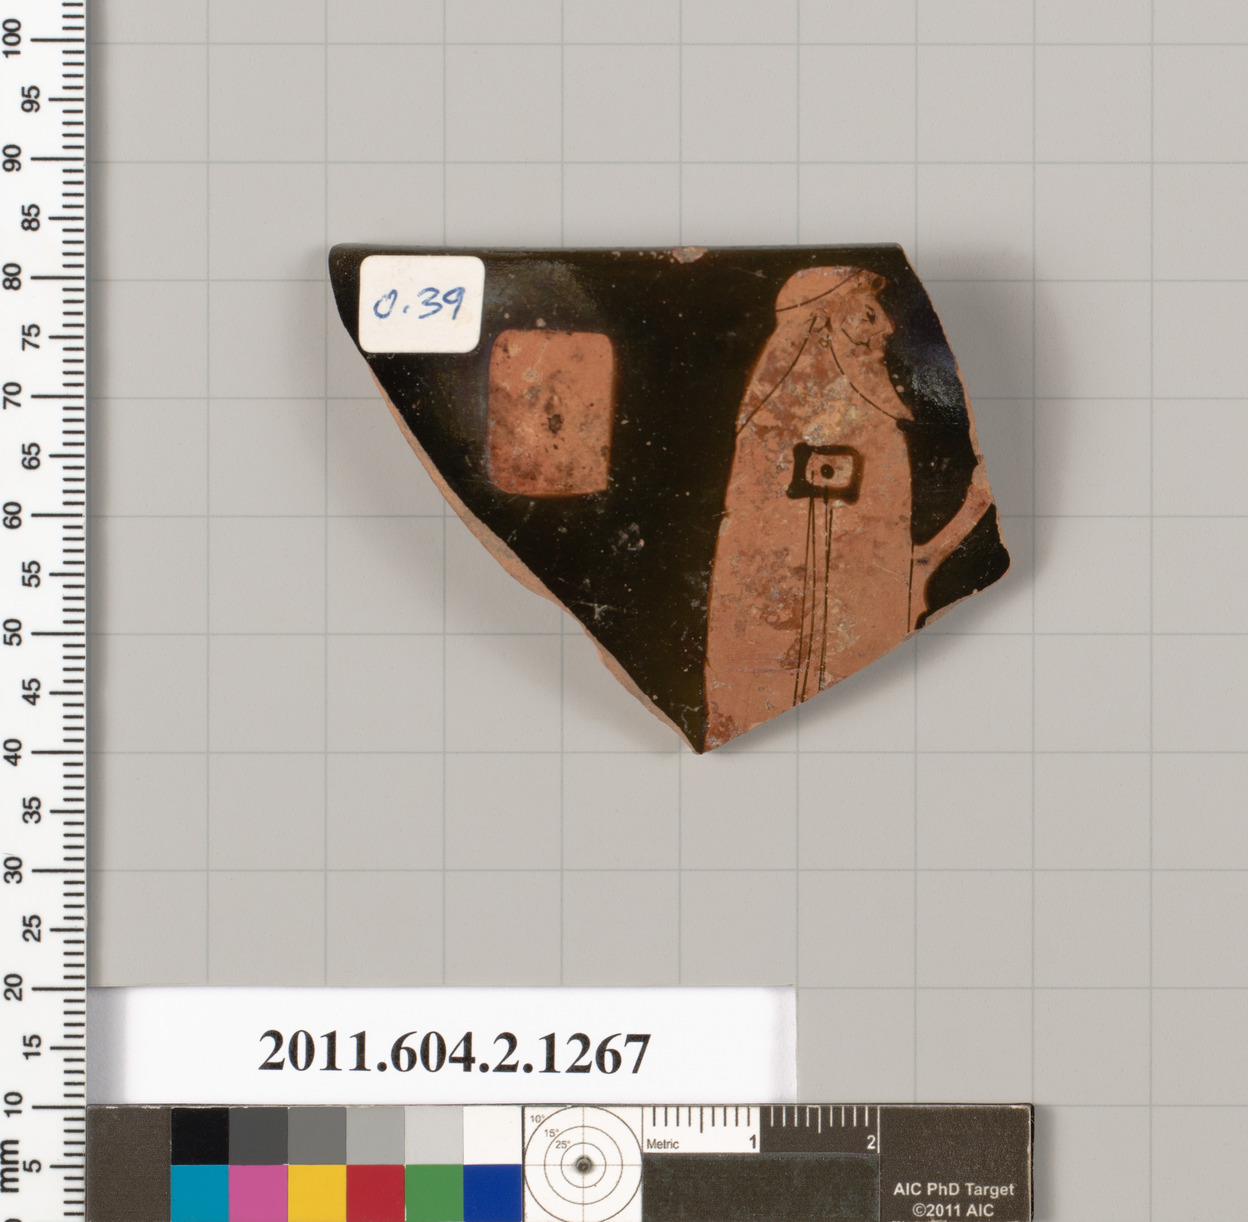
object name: skyphos fragment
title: Terracotta rim fragment of a skyphos (deep drinking cup)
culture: greek, attic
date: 475-451 BCE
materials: terracotta